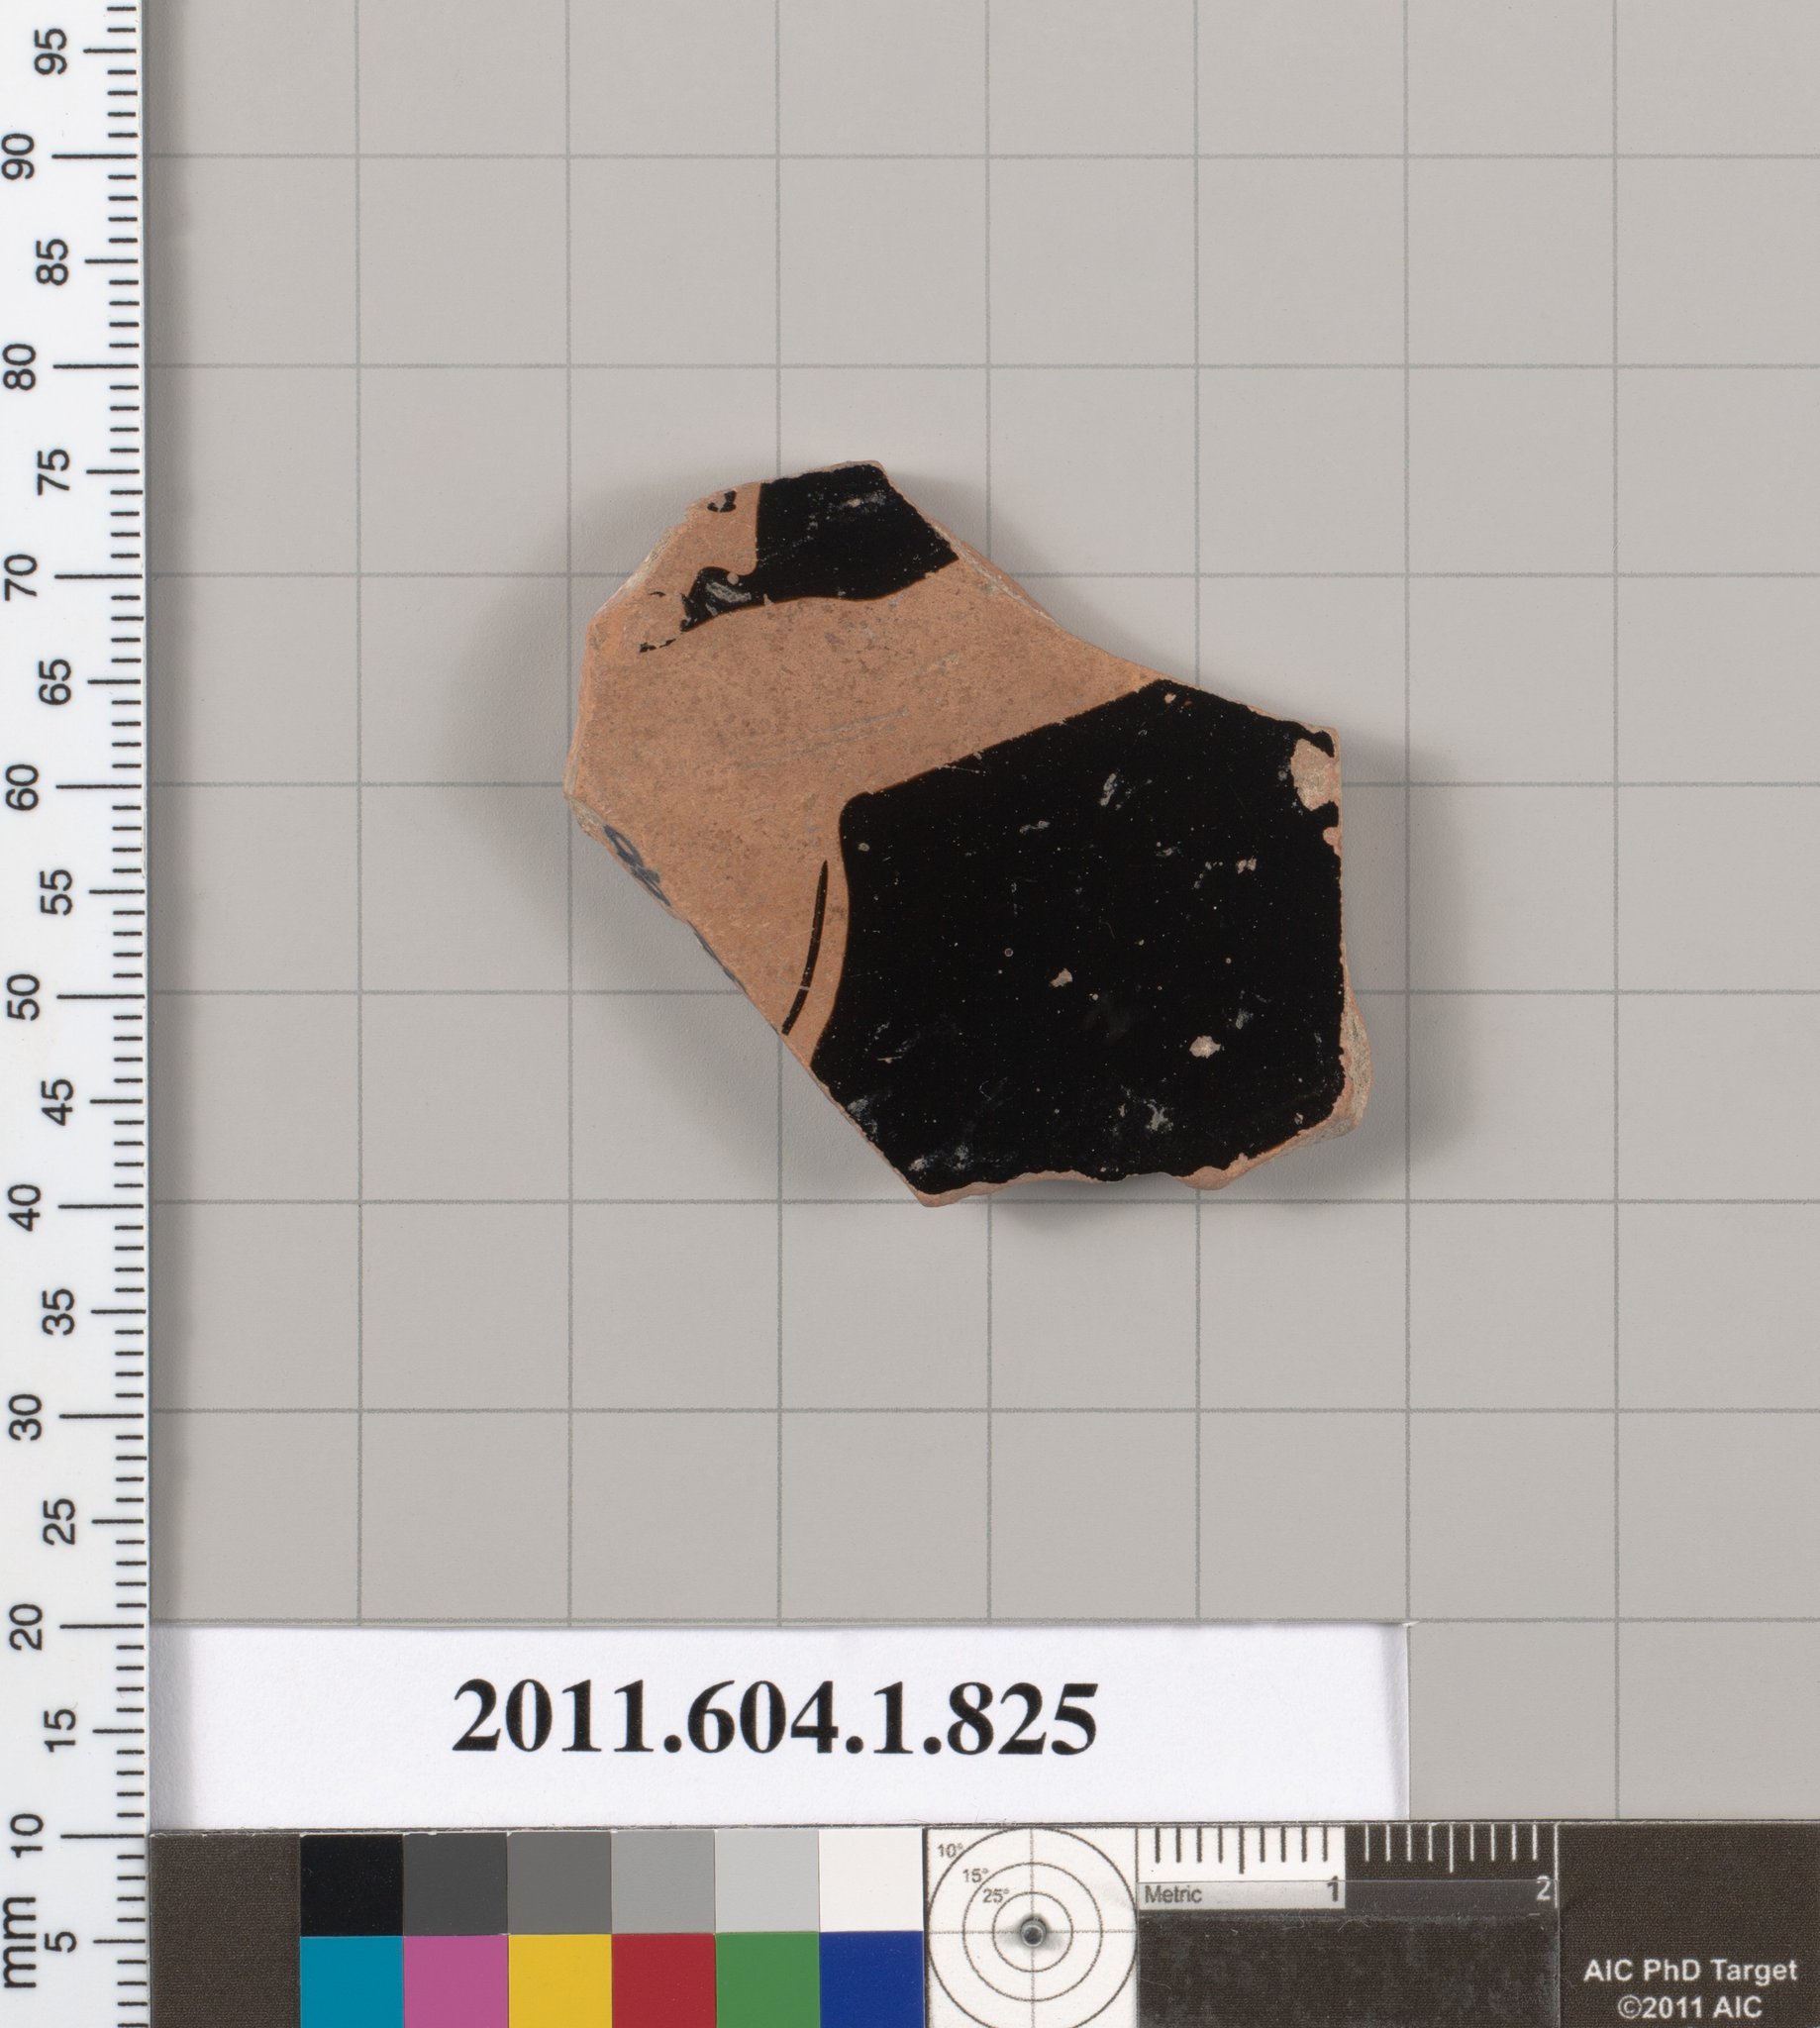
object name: kylix fragment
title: Terracotta fragment of a kylix (drinking cup)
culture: greek, attic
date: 475-451 BCE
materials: terracotta